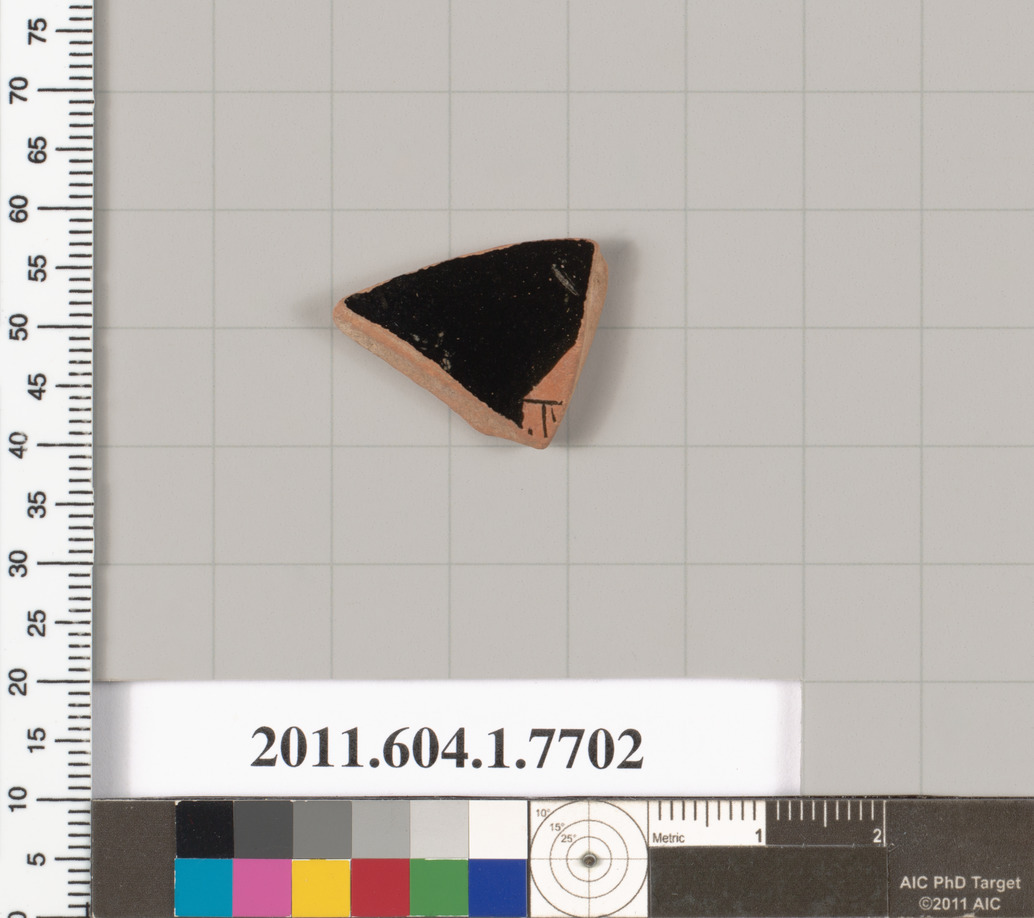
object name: kylix fragment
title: Terracotta fragment of a kylix (drinking cup)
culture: greek, attic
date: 460-450 BCE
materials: terracotta